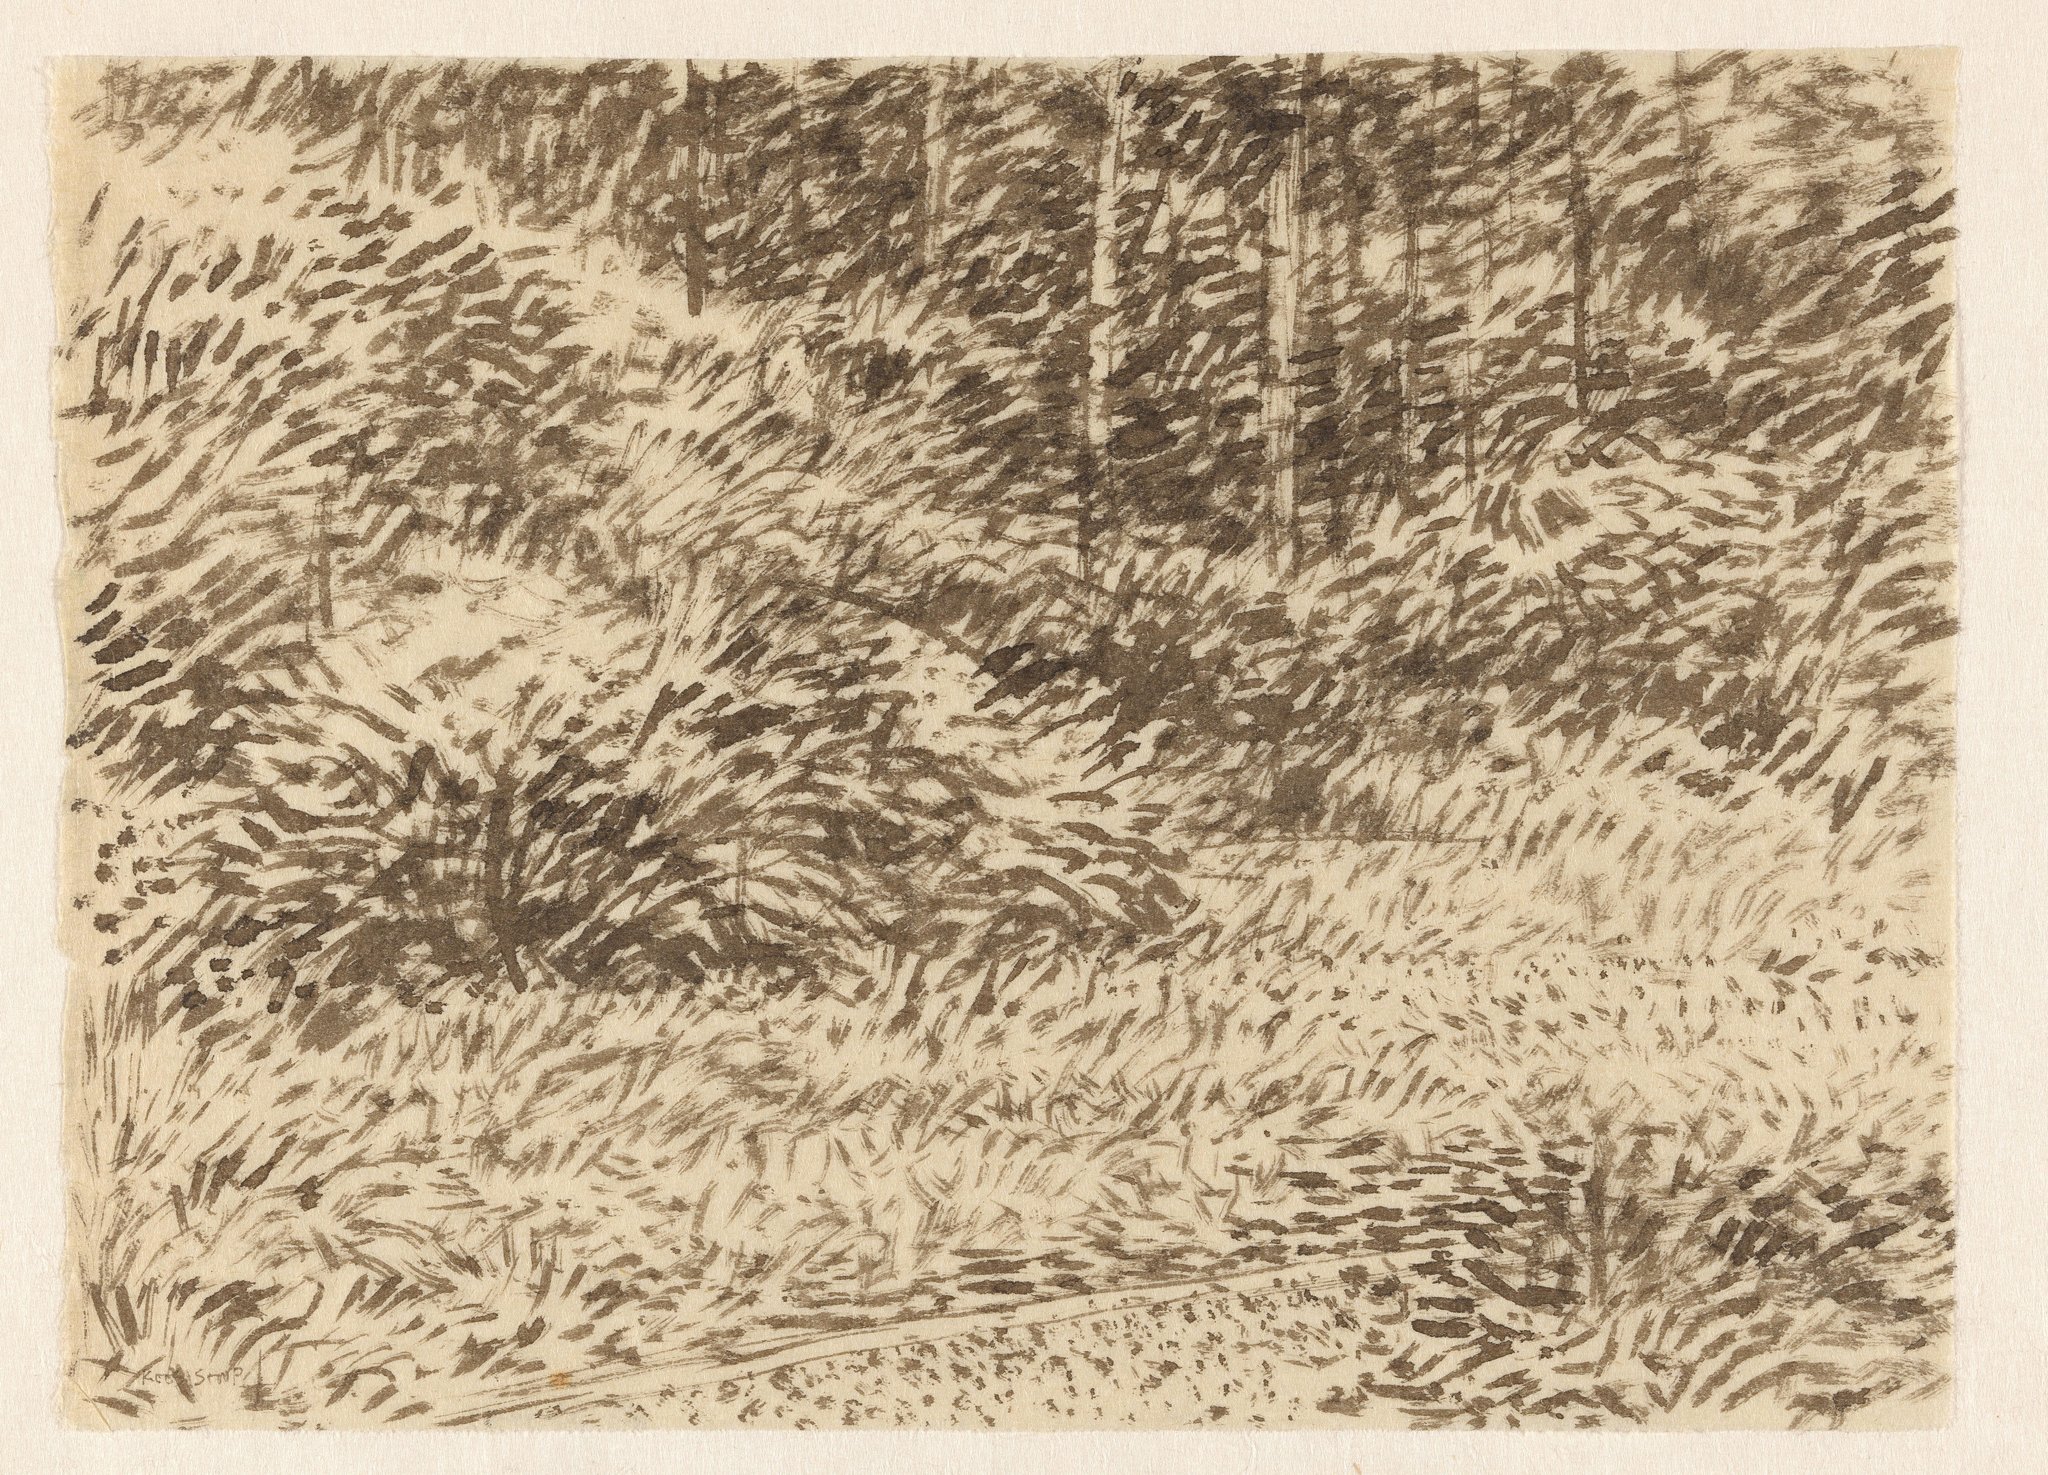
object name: drawing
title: Gras, struikgewas en bomen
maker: kees stoop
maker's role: draughtsman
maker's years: 1929-2019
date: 1944-1990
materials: ink, paper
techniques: brush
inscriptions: signature: ‘KEES STOOP’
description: Gras, struikgewas en bomen, opgezet in korte toetsen.